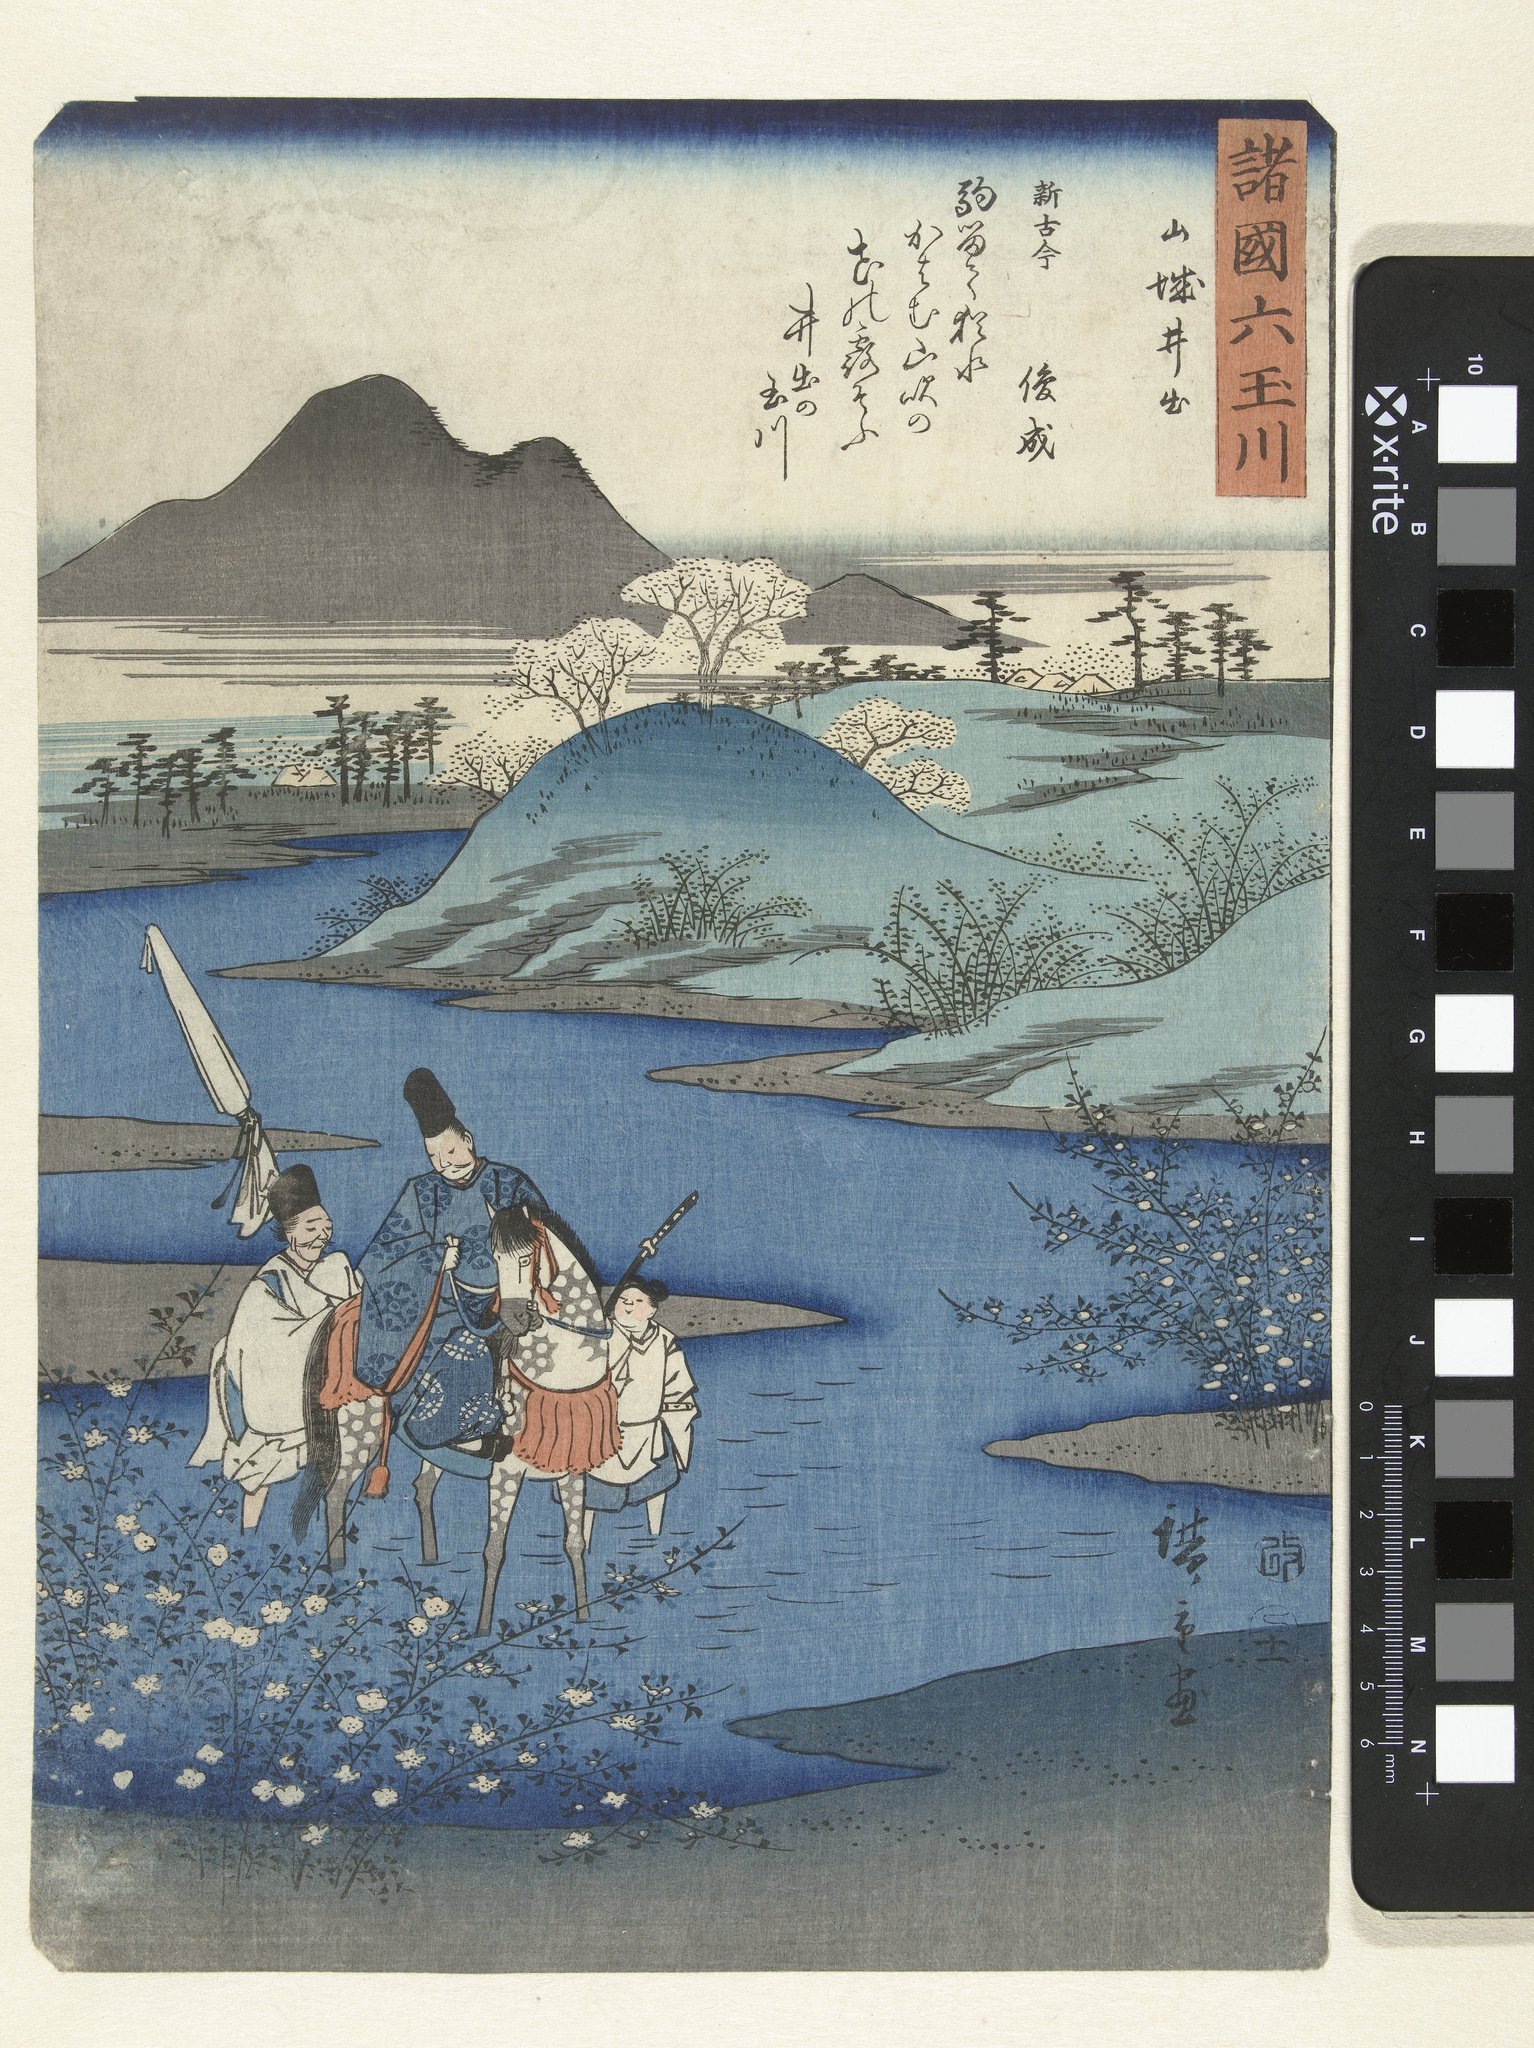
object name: print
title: Zes Juwelen rivieren in verschillende provinciën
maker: utagawa hiroshige (i)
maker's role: draughtsman, print maker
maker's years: 1797-1858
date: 1811-1857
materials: paper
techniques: woodcut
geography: japan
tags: riding a horse, ass, or mule; rider, horseman, river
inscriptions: date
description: Man te paard met twee begeleiders, in ondiepe rivier, kijkend naar een Yamabuki struik; berglandschap op de achtergrond.